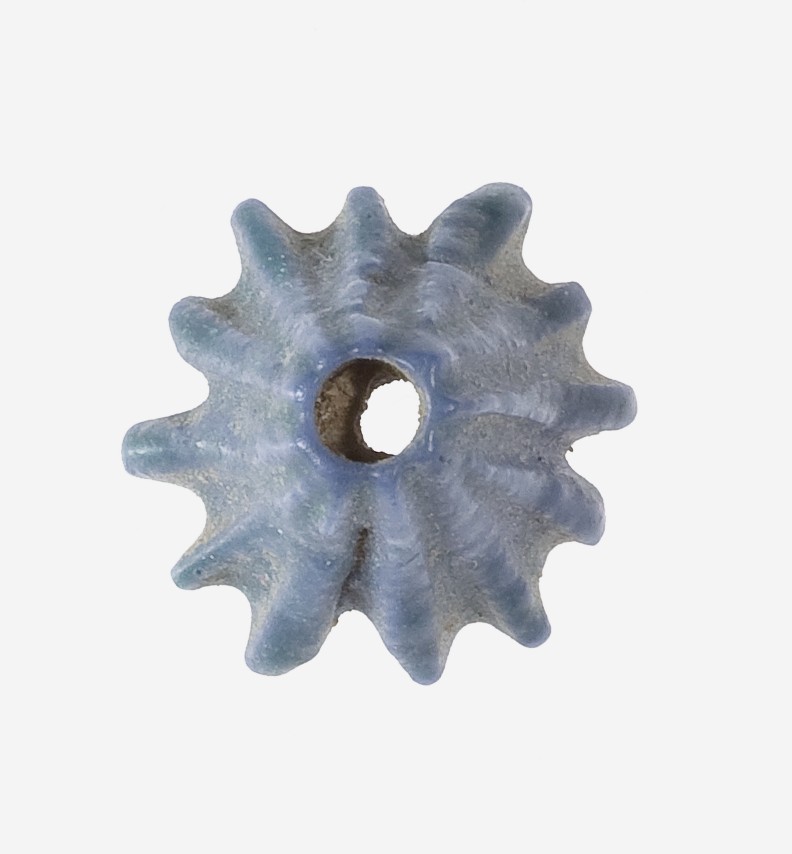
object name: pendant, cornflower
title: Pendant: Petals of Cornflower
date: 1390-1352 BCE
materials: faience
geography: egypt